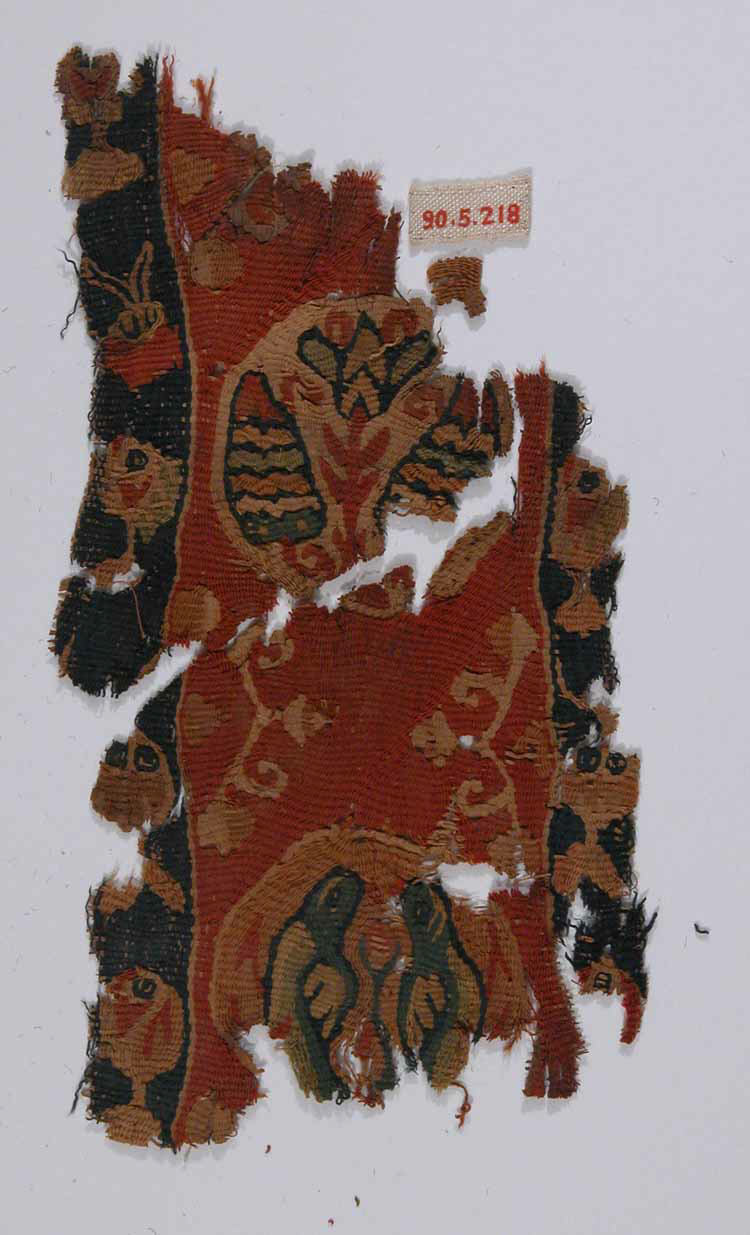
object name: textile fragment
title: Fragment of a Shoulder Band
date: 501-600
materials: linen, wool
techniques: weave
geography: egypt